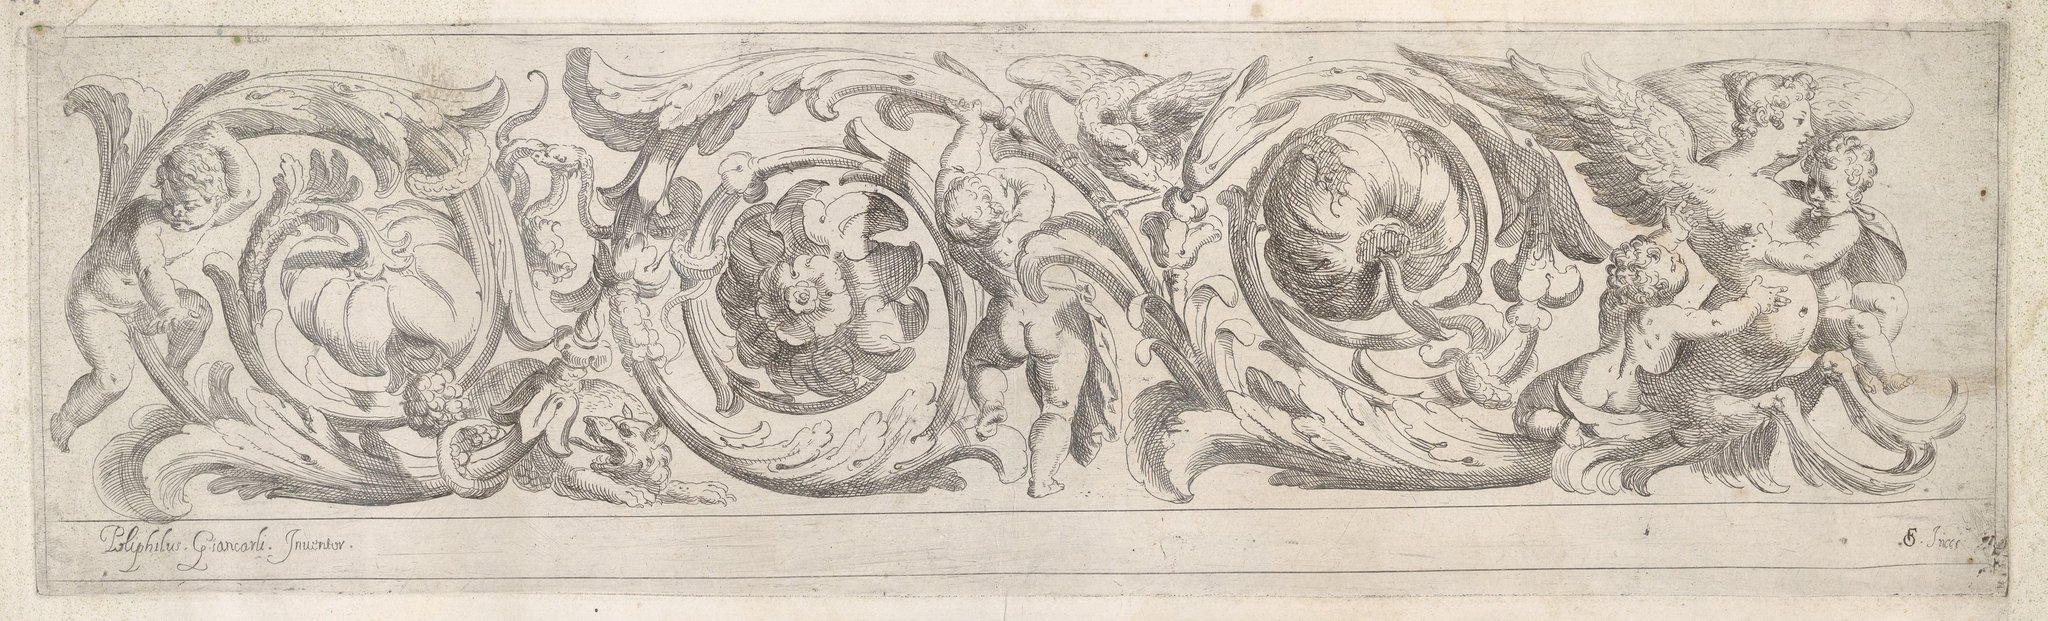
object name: collection ornament architecture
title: Disegni Varij di Polifilo Zancarli (Friezes)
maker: polifilo giancarli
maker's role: artist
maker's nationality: italian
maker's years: 1600-1625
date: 1625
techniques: etching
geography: italy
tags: eagles,ornament,putti